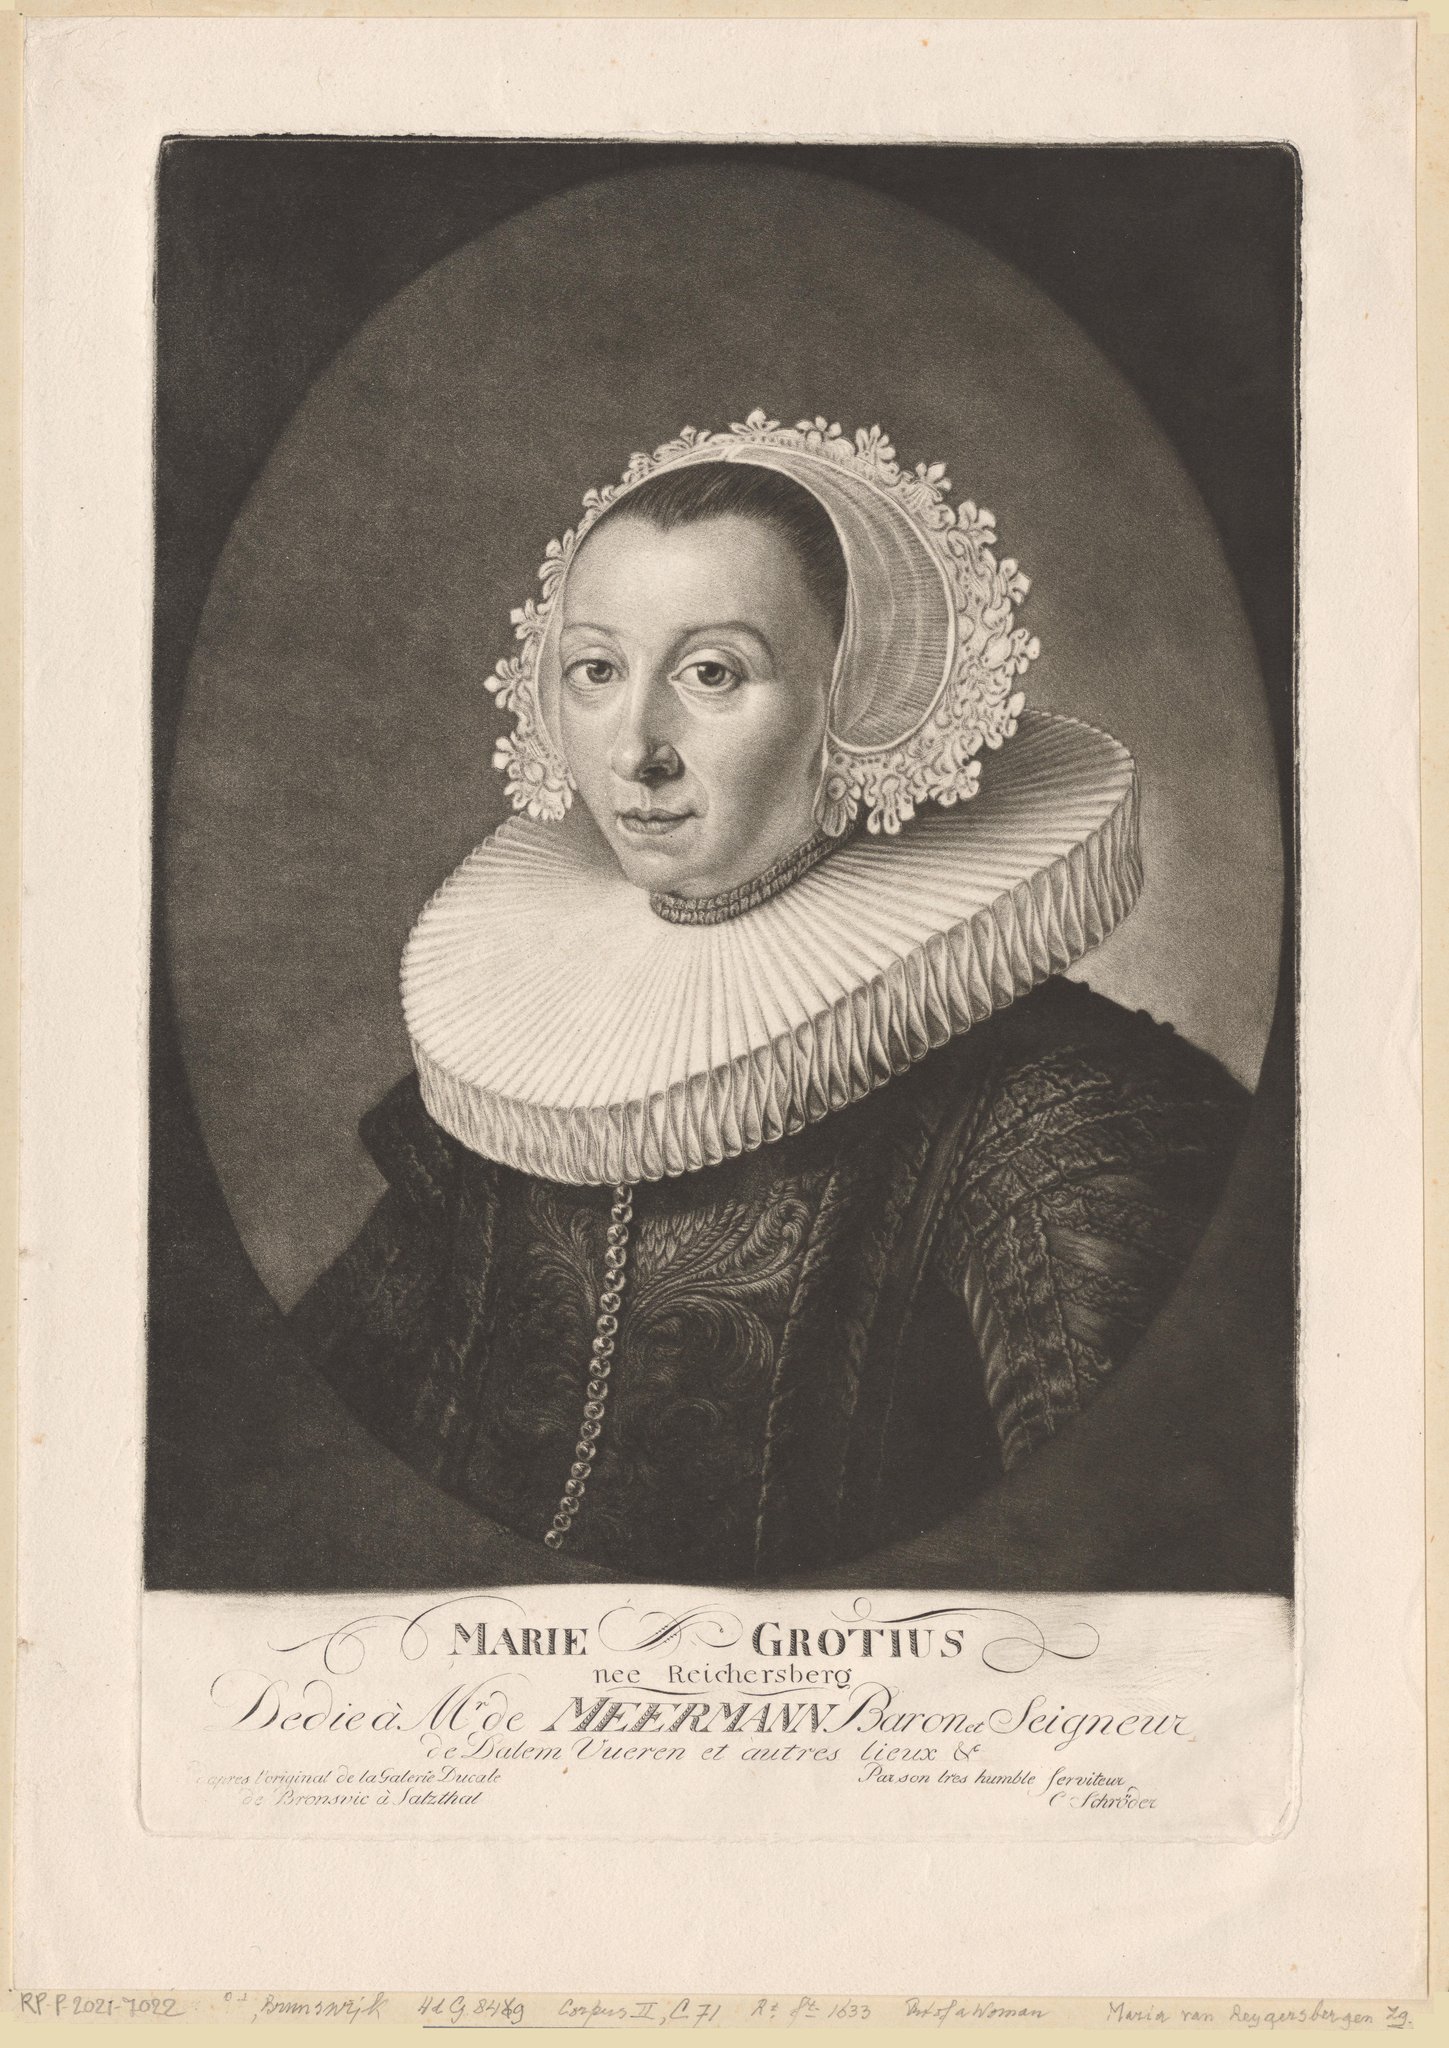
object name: print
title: Portret van Maria van Reigersberch (1589-1653)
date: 1763-1815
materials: paper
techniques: engraving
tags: the hague, historical persons - bb - woman